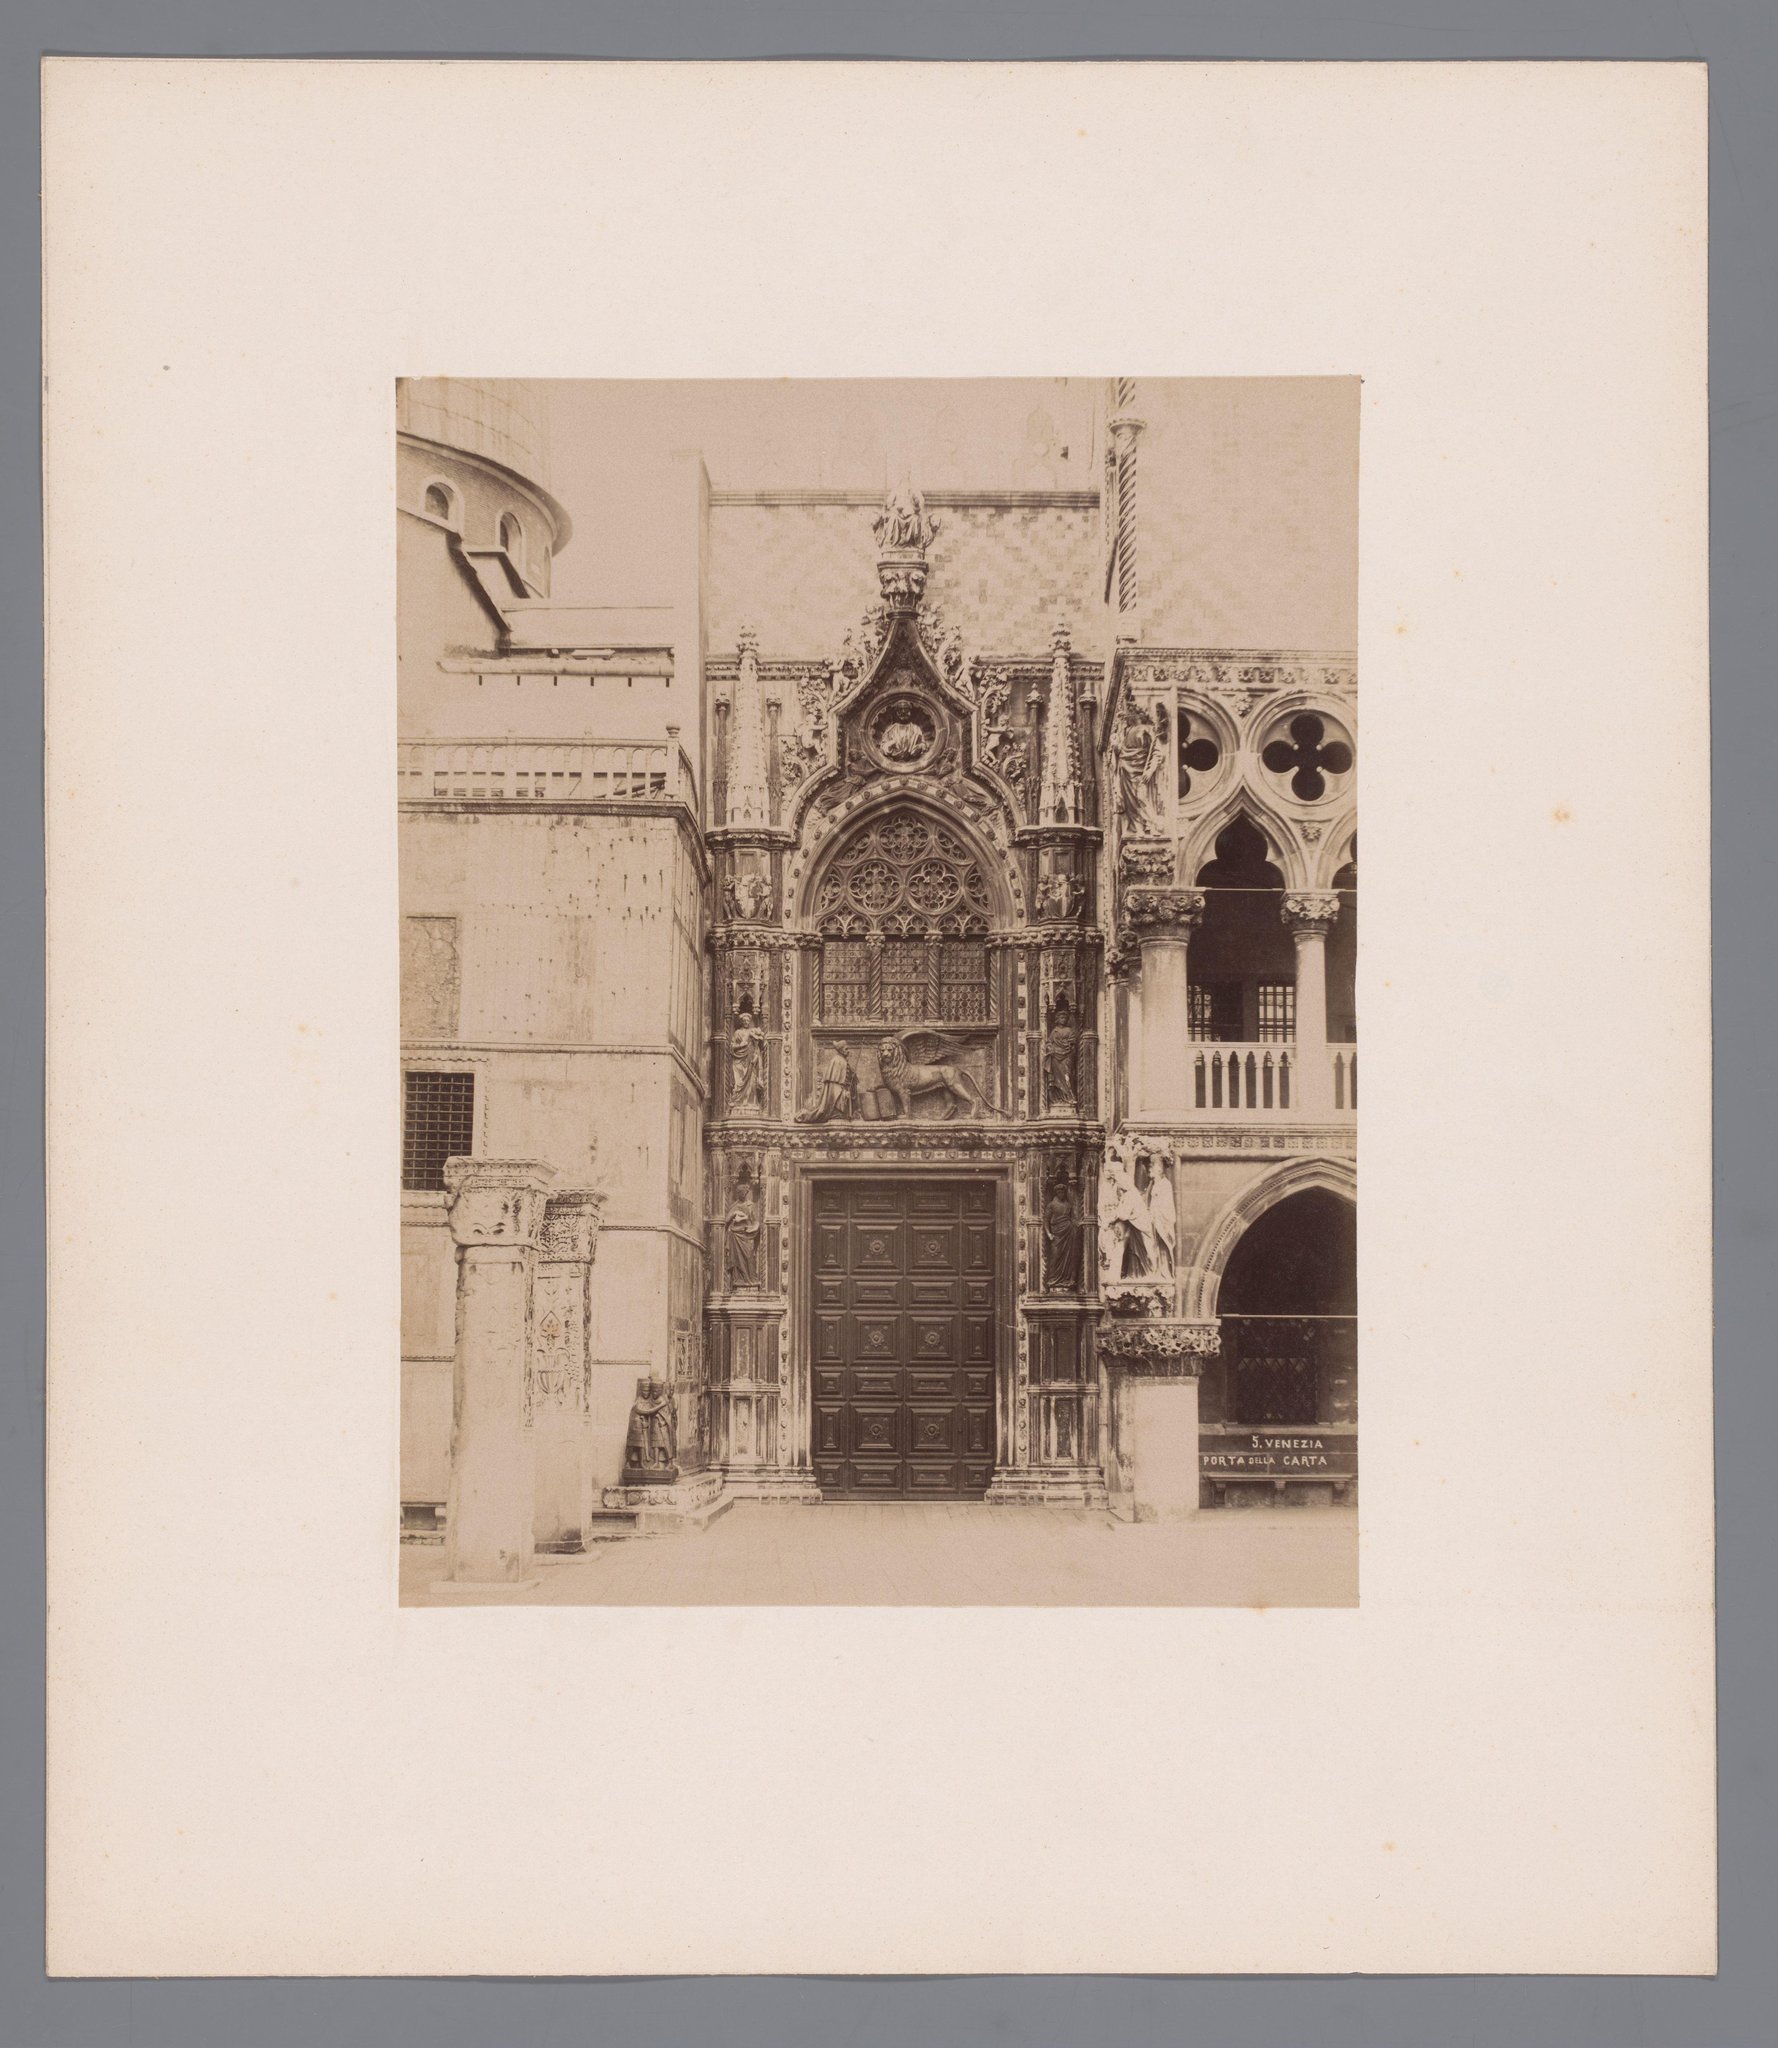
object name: photograph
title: Porta della Carta in de basiliek van San Marco te Venetië, Italië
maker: Anonymous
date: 1851-1900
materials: cardboard, paper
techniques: albumen print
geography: venice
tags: parts of church exterior and annexes: portal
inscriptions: number: ‘5.’